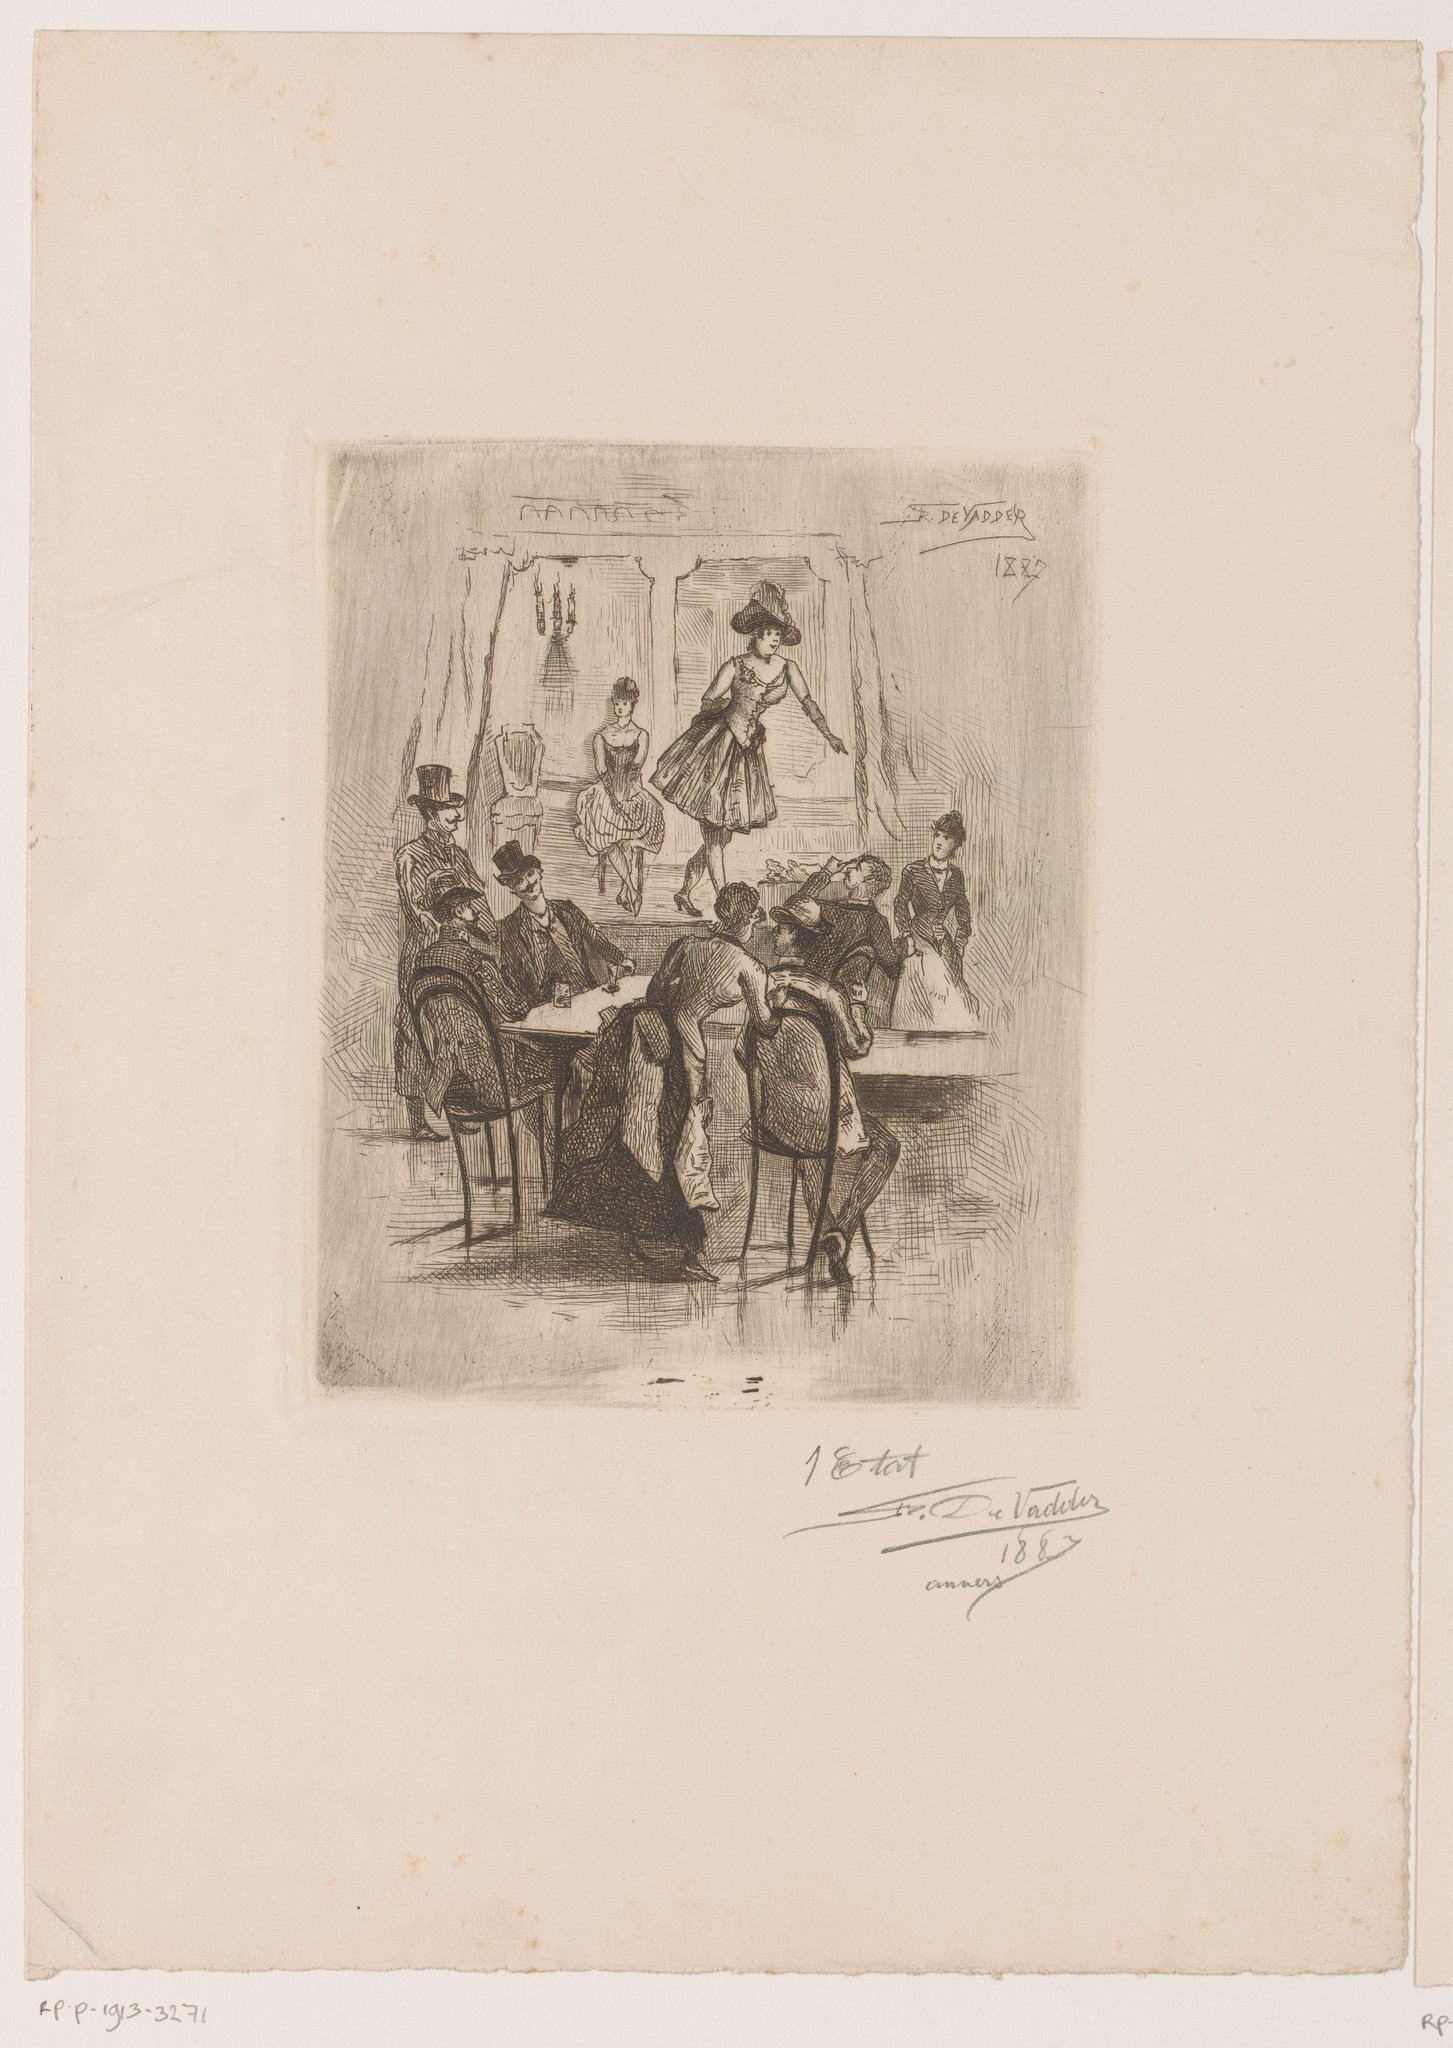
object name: print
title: Café Chantant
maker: frans de vadder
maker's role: print maker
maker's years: 1862-1936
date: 1887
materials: paper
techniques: etching, intaglio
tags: theatre, theatrical performance, vocal music, singing, indoor recreation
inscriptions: inscription: ‘1 Etat; 1887; Anvers’, collector's mark: Lugt 2228